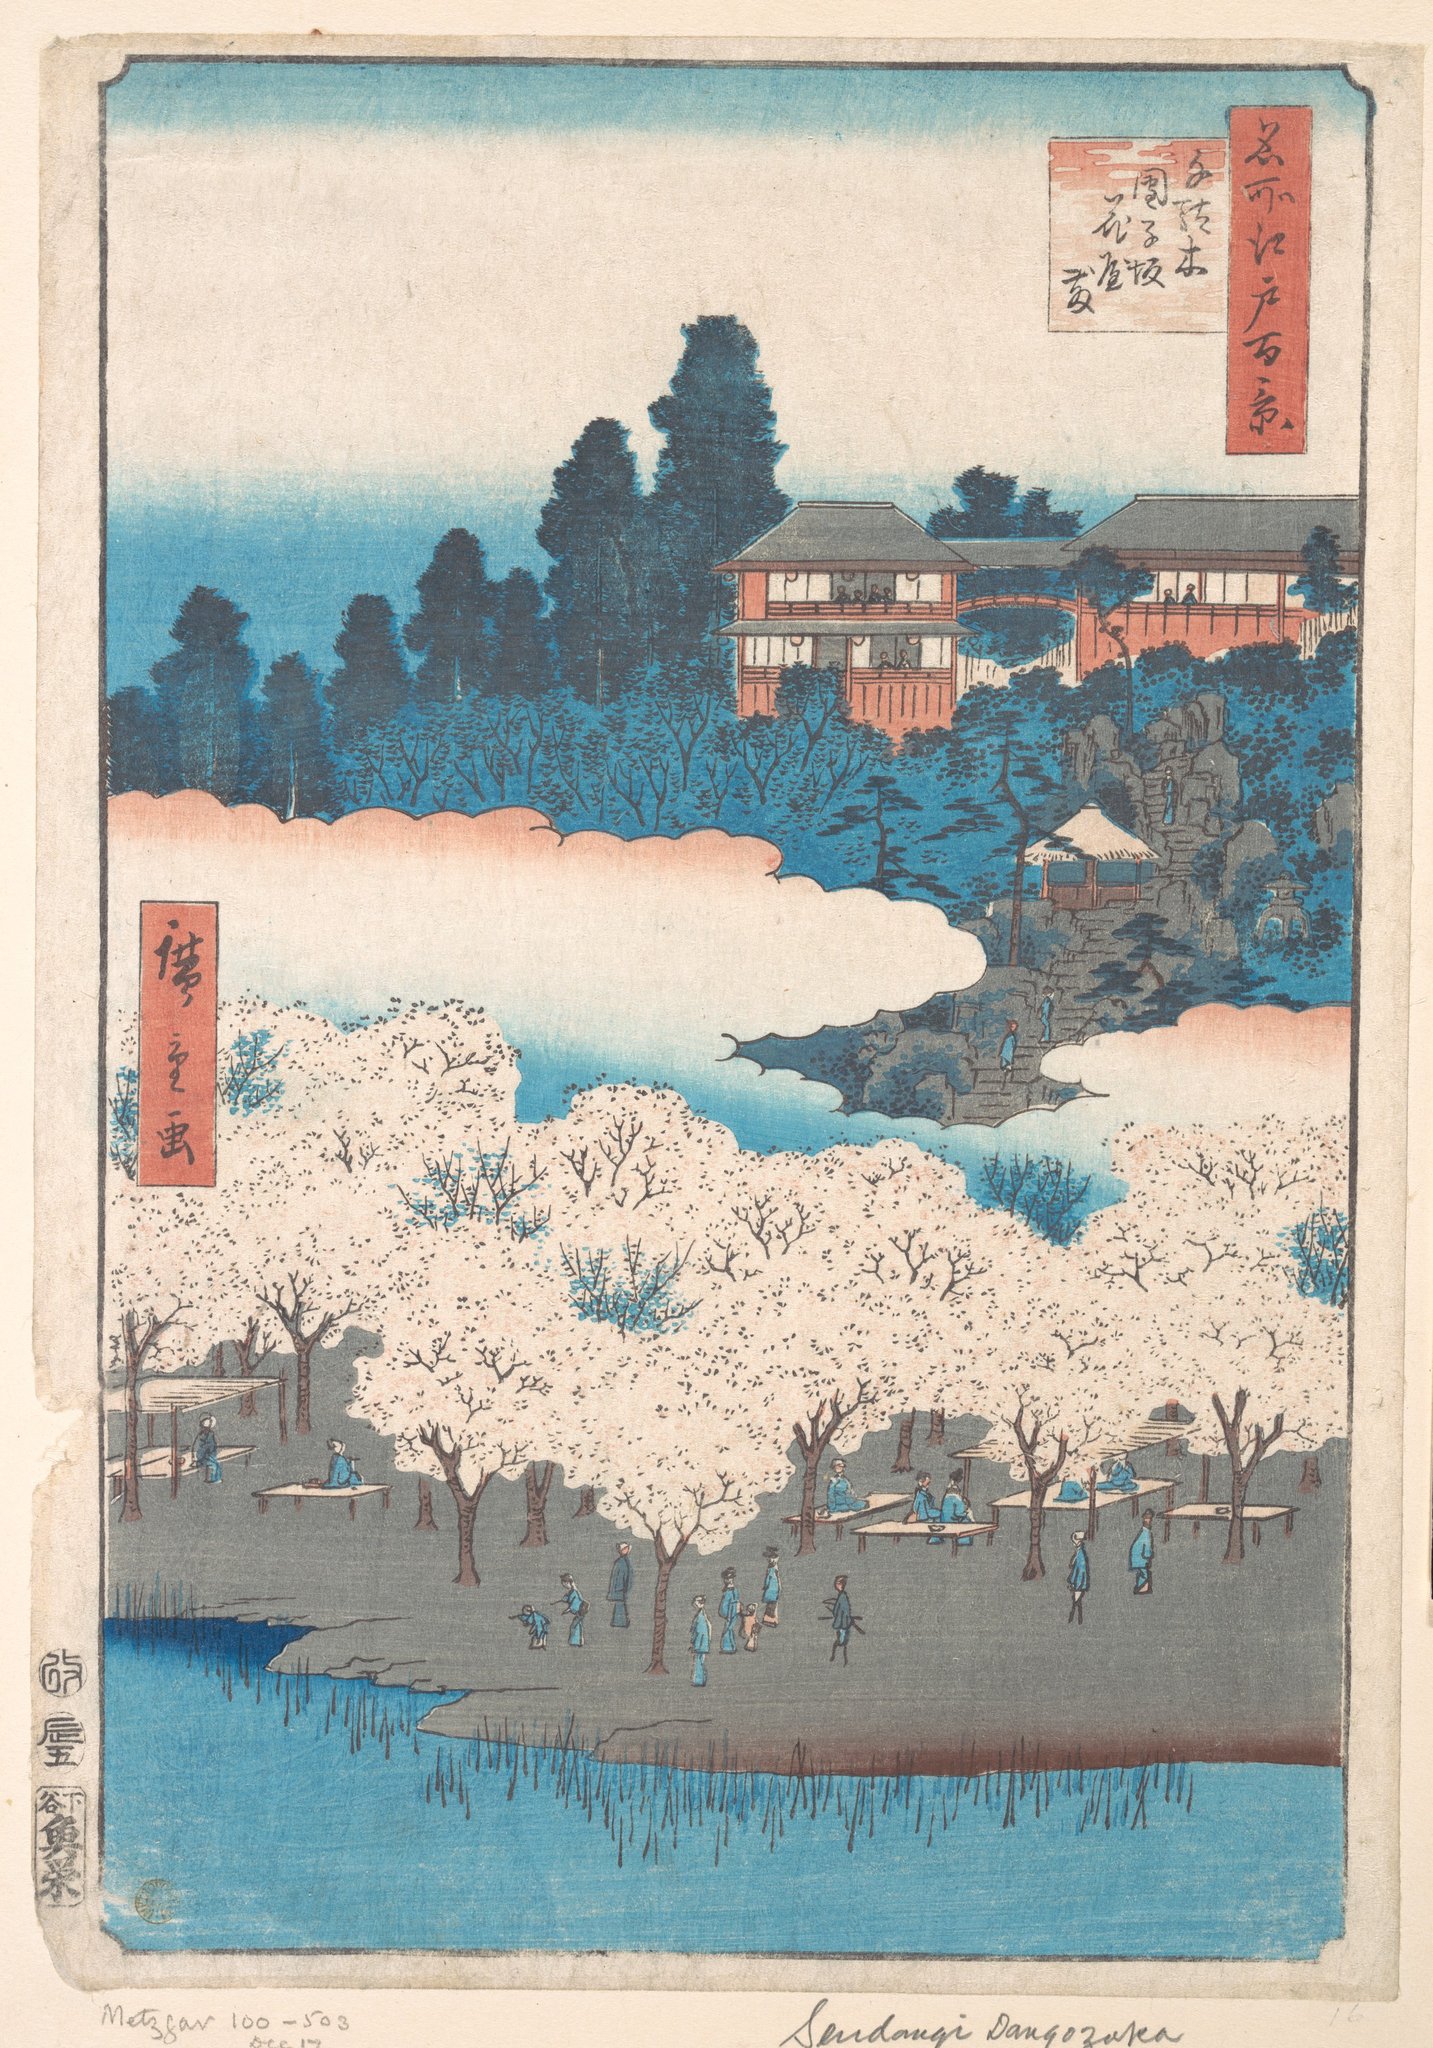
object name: print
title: Sendagi Dangozaka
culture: japanese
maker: utagawa hiroshige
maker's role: artist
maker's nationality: japanese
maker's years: 1797-1858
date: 1856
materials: ink, paper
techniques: woodblock print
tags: landscapes